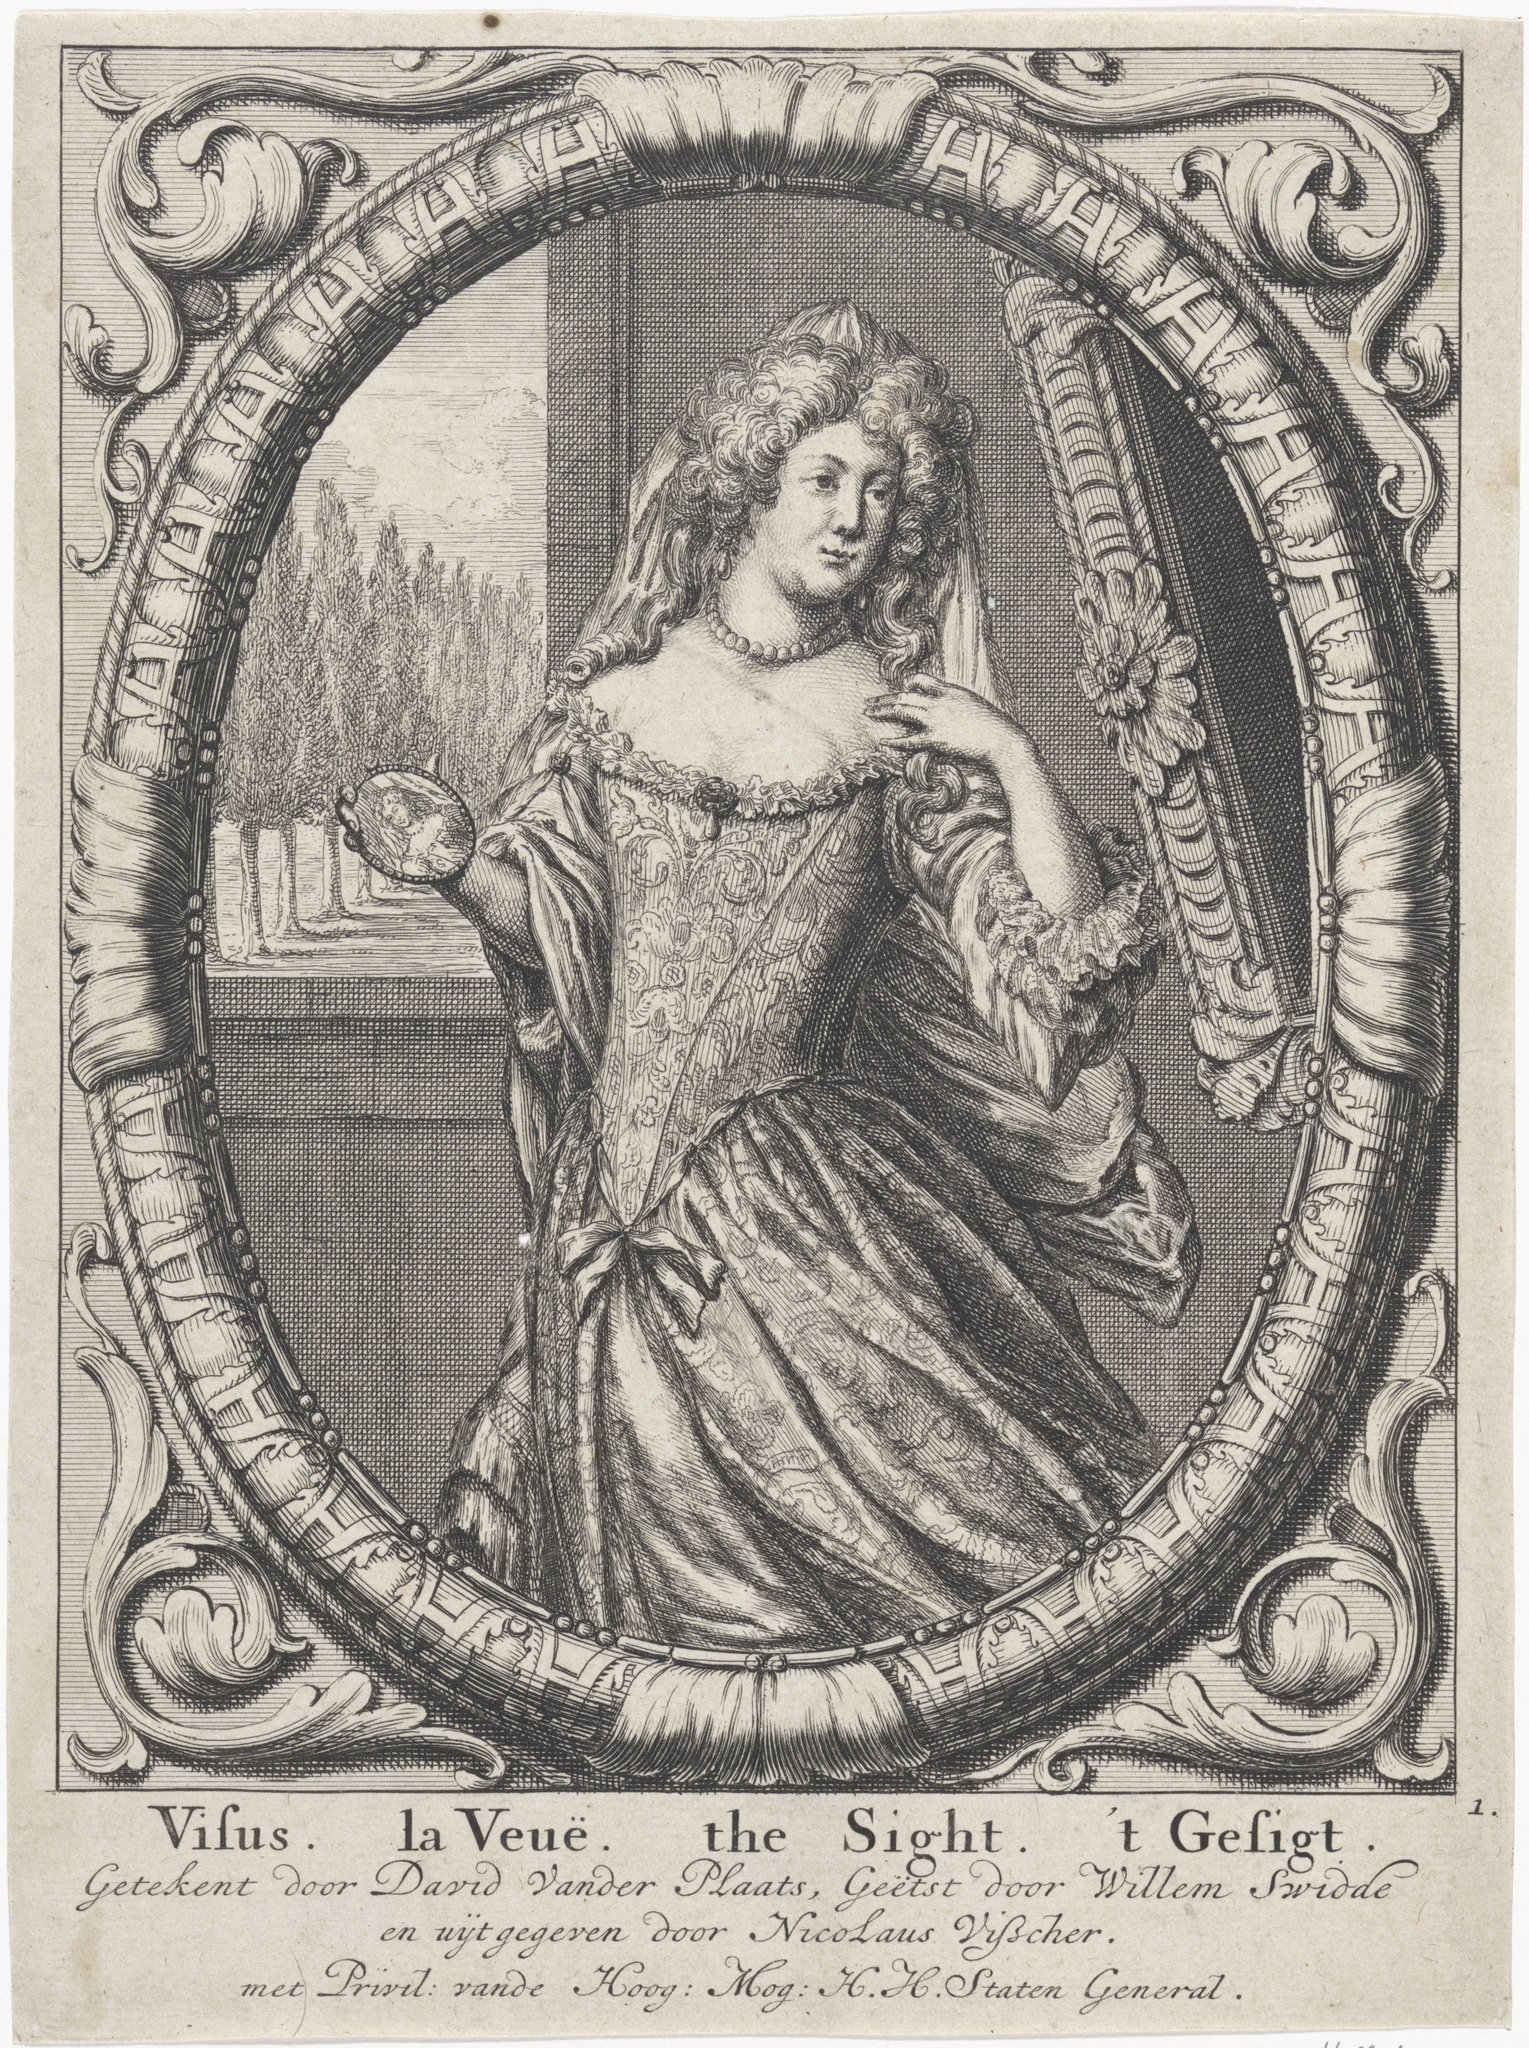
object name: print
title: Vijf zintuigen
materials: paper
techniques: engraving, etching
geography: amsterdam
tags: sight, looking (one of the five senses), mirror - aa - (for) women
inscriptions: collector's mark: Lugt 2228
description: Een rijk geklede dame met een handspiegel in de hand kijkt over haar schouder naar een spiegel aan de wand. Door een raam is er zicht op een bomenrij. In een bewerkte ovaal met randversiering. Onder de afbeelding de titel van de prent in het Latijn, Frans, Engels en Nederlands. Rechtsonder genummerd "1".